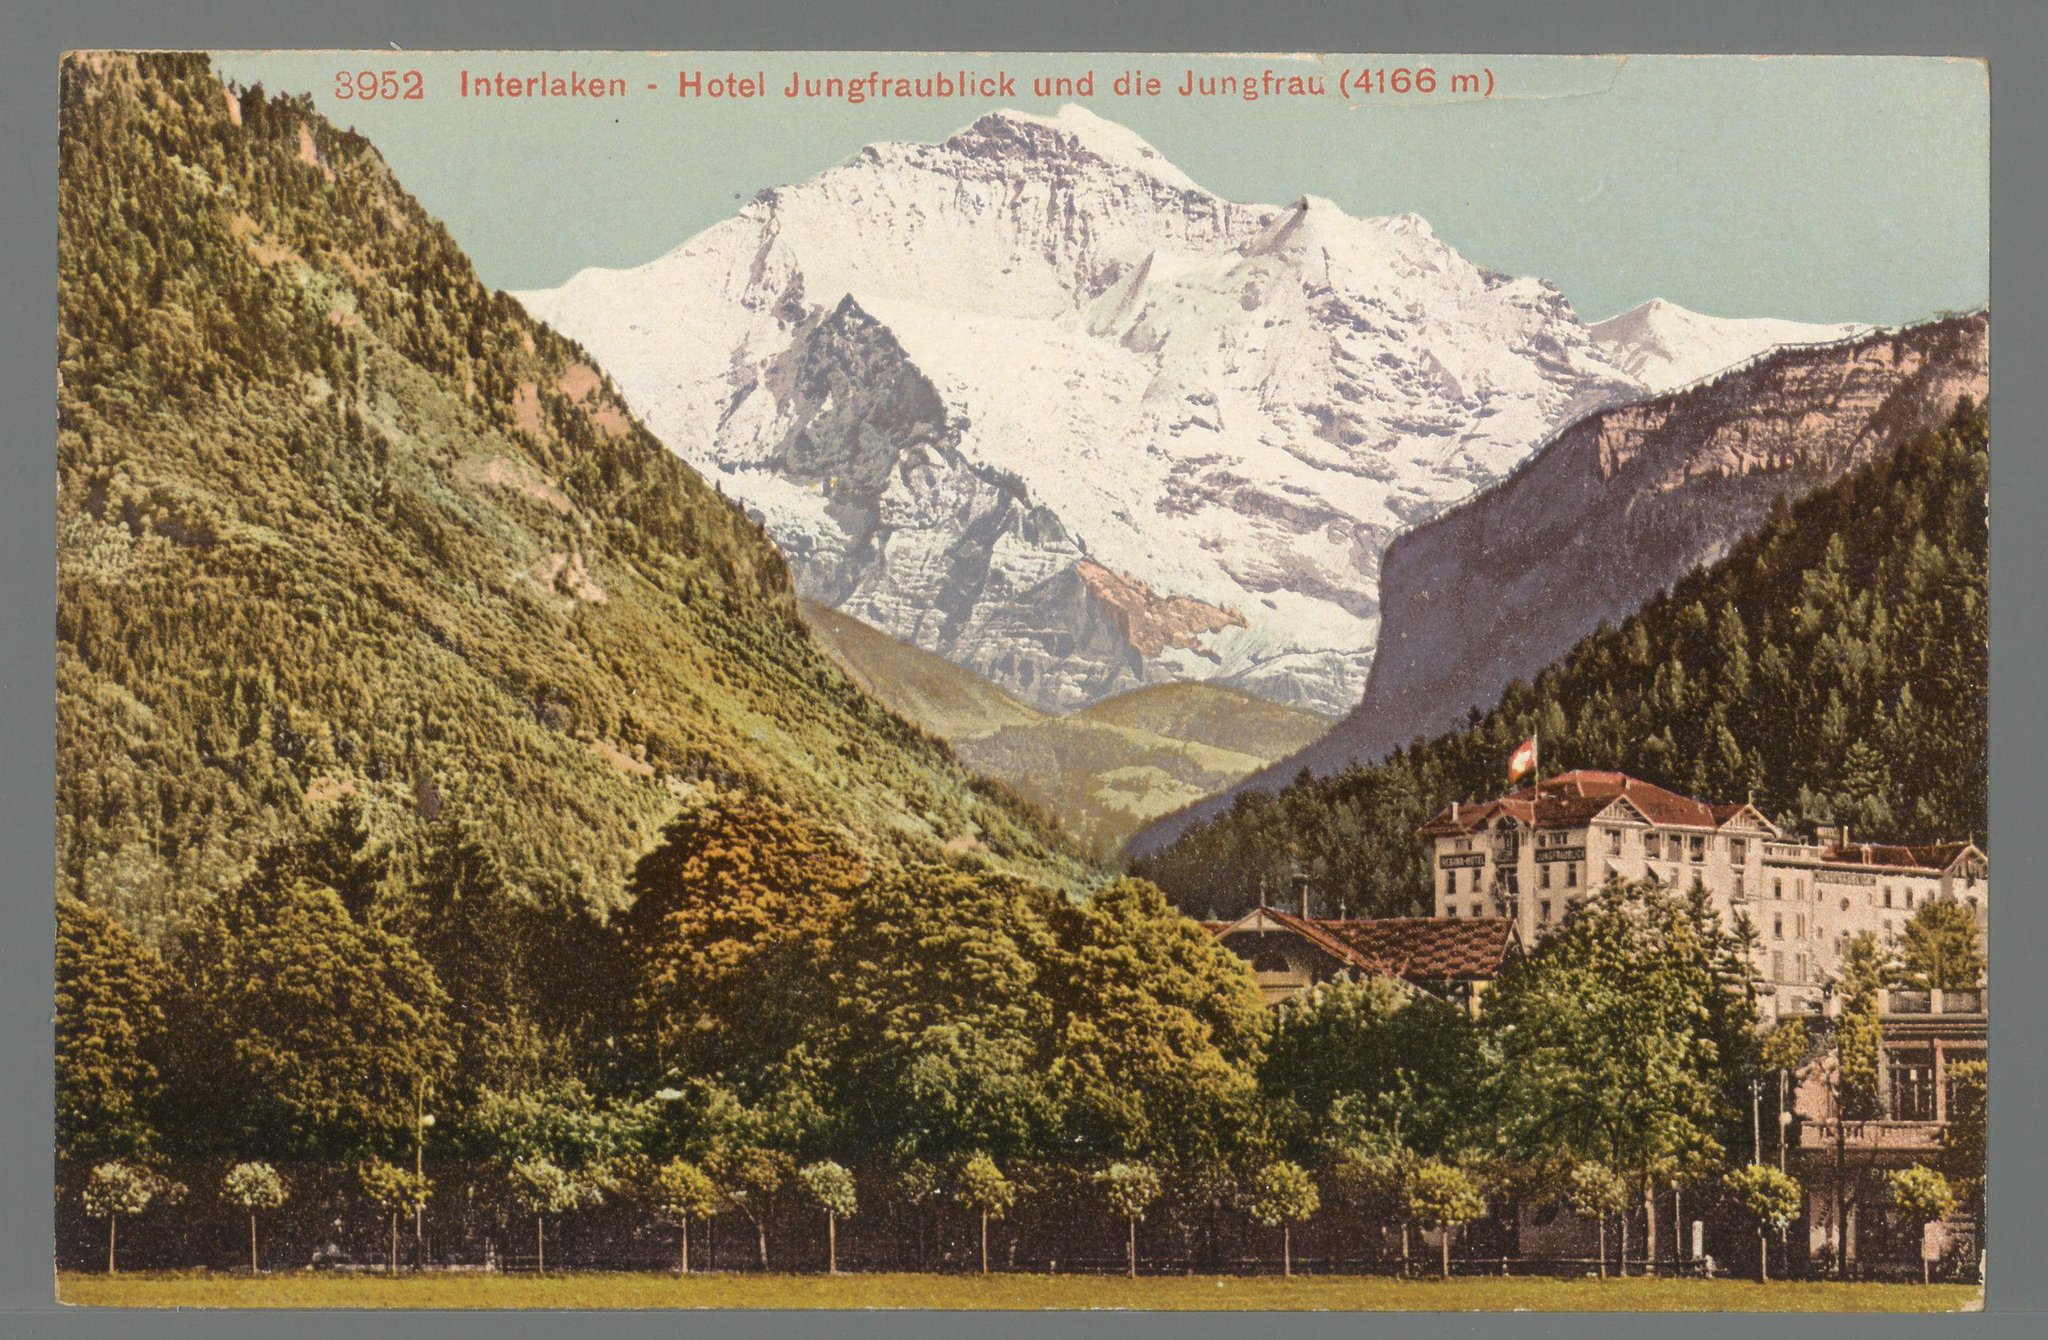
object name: photomechanical print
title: Interlaken. Hotel Jungfraublick und die Jungfrau (4166 m)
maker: Anonymous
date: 1905-1920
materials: cardboard, photographic process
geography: zurich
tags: mountain-range, snow peaks, hotel, hostelry, inn